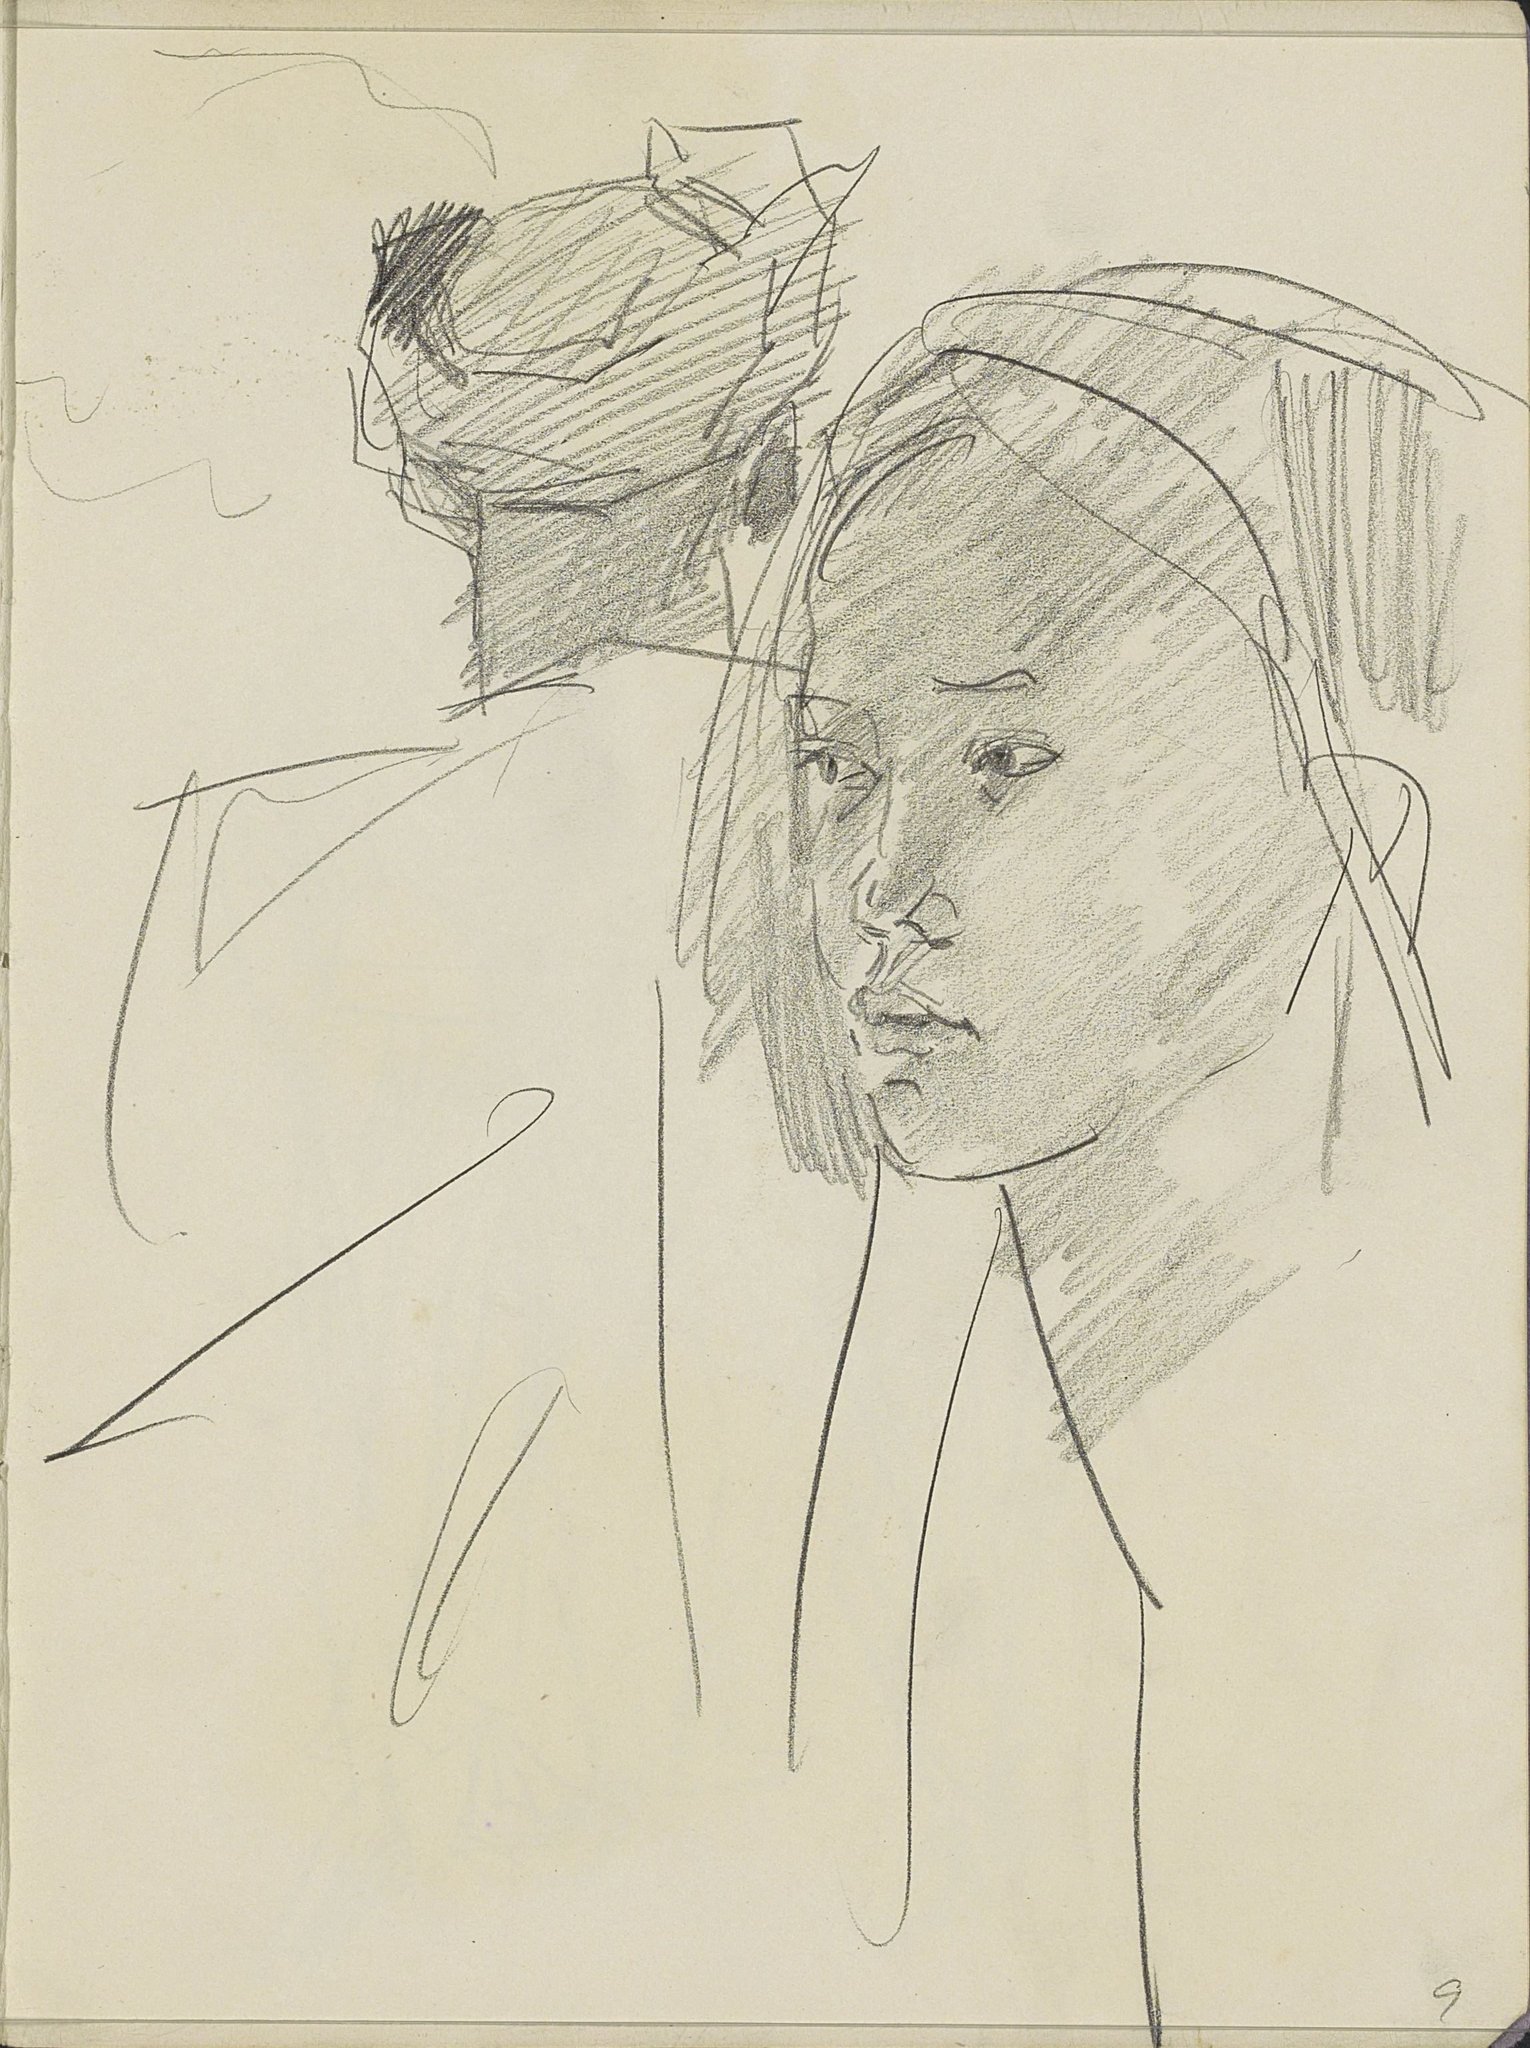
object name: sketchbook leaf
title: Vrouwenhoofd en een man, op de rug gezien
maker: isaac israels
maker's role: draughtsman, painter, print maker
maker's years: 1865-1934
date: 1875-1934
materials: paper, pencil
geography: the hague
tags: adult man (+ back view), head (human) - aa - female human figure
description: Beiden dragen een doek op hun hoofd. Blad 9 recto uit schetsboek XXIV met 10 bladen.